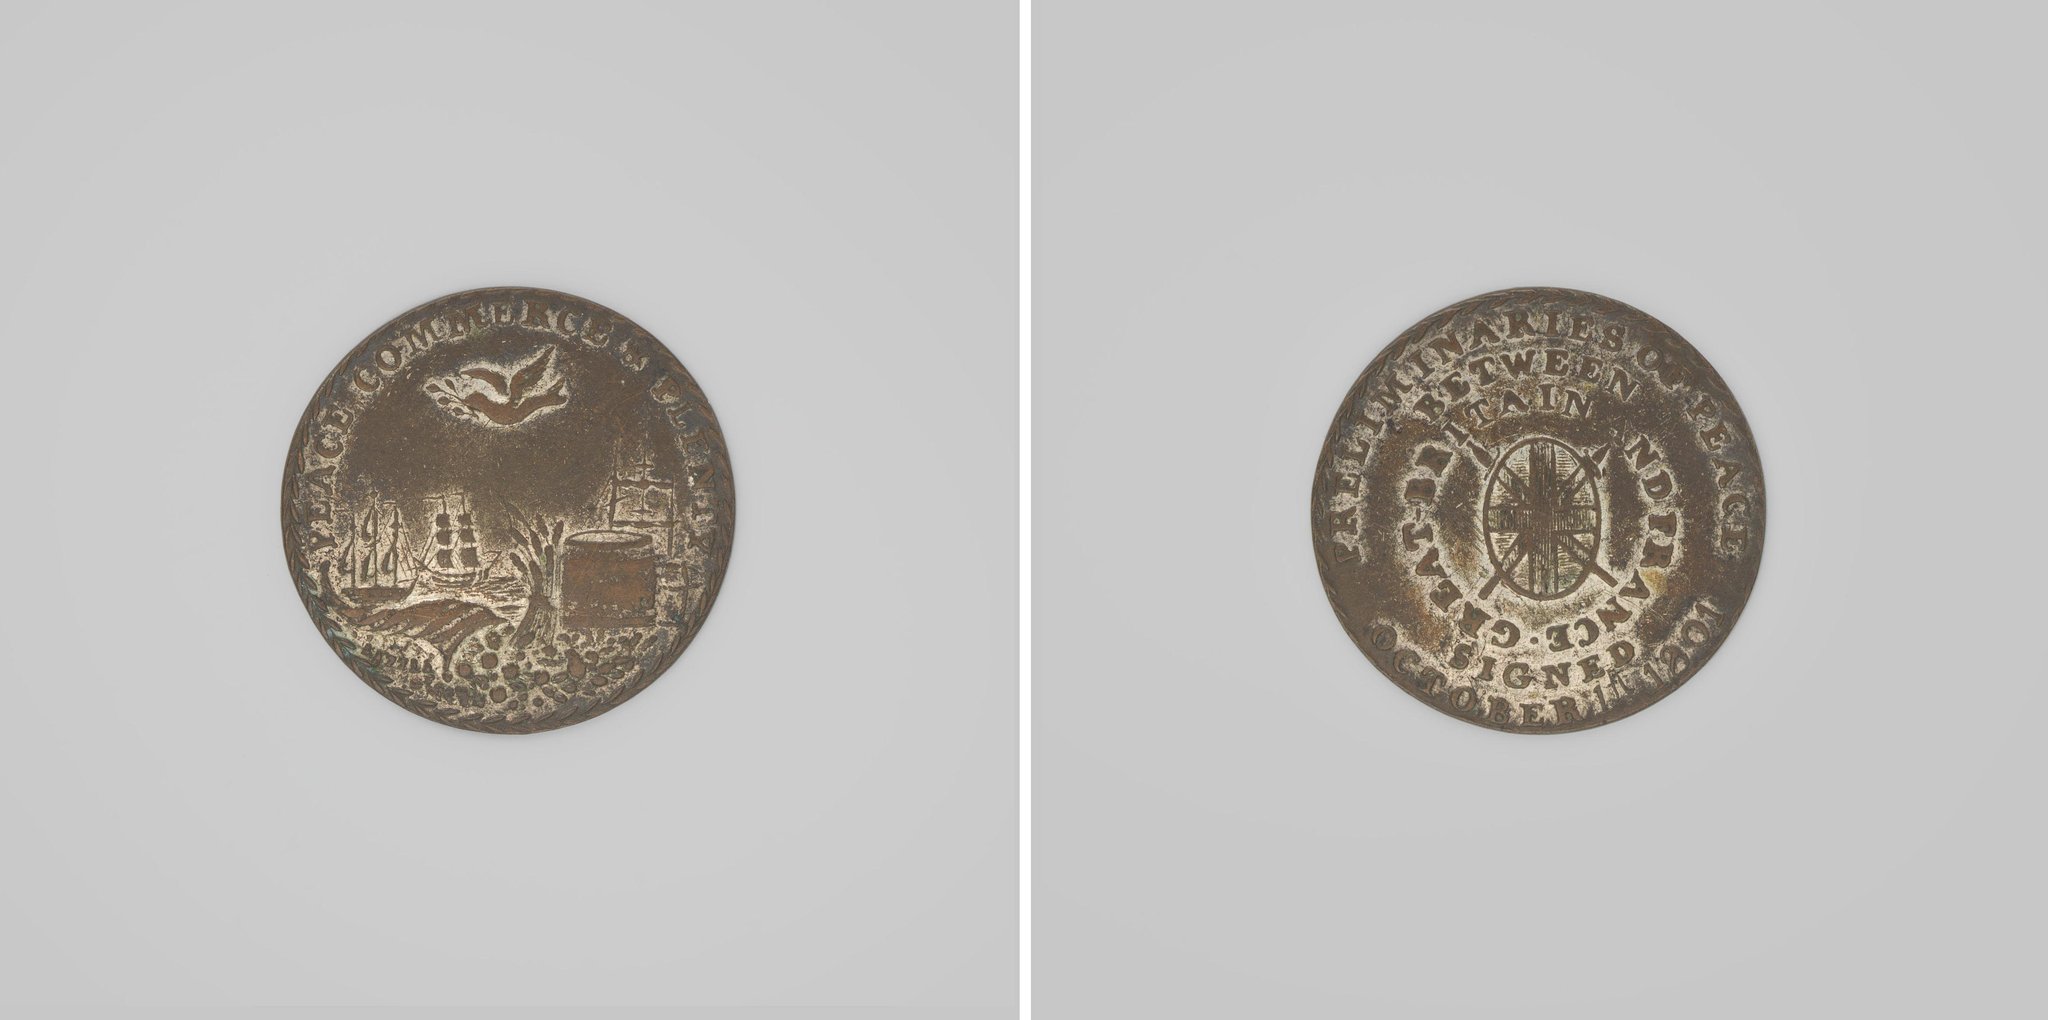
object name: history medal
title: Voorlopige Vrede van Amiens tussen Engeland en Frankrijk 1801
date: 1801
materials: copper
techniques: striking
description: Koperen penning, op de voorzijde een hoorn des overvloeds, korenaren en een vat, op de achtergrond schepen en een duif met olijftak, met omschrift, op de keerzijde een ovaal Brits wapenschild op gekruiste speren, met driedubbel omschrift.